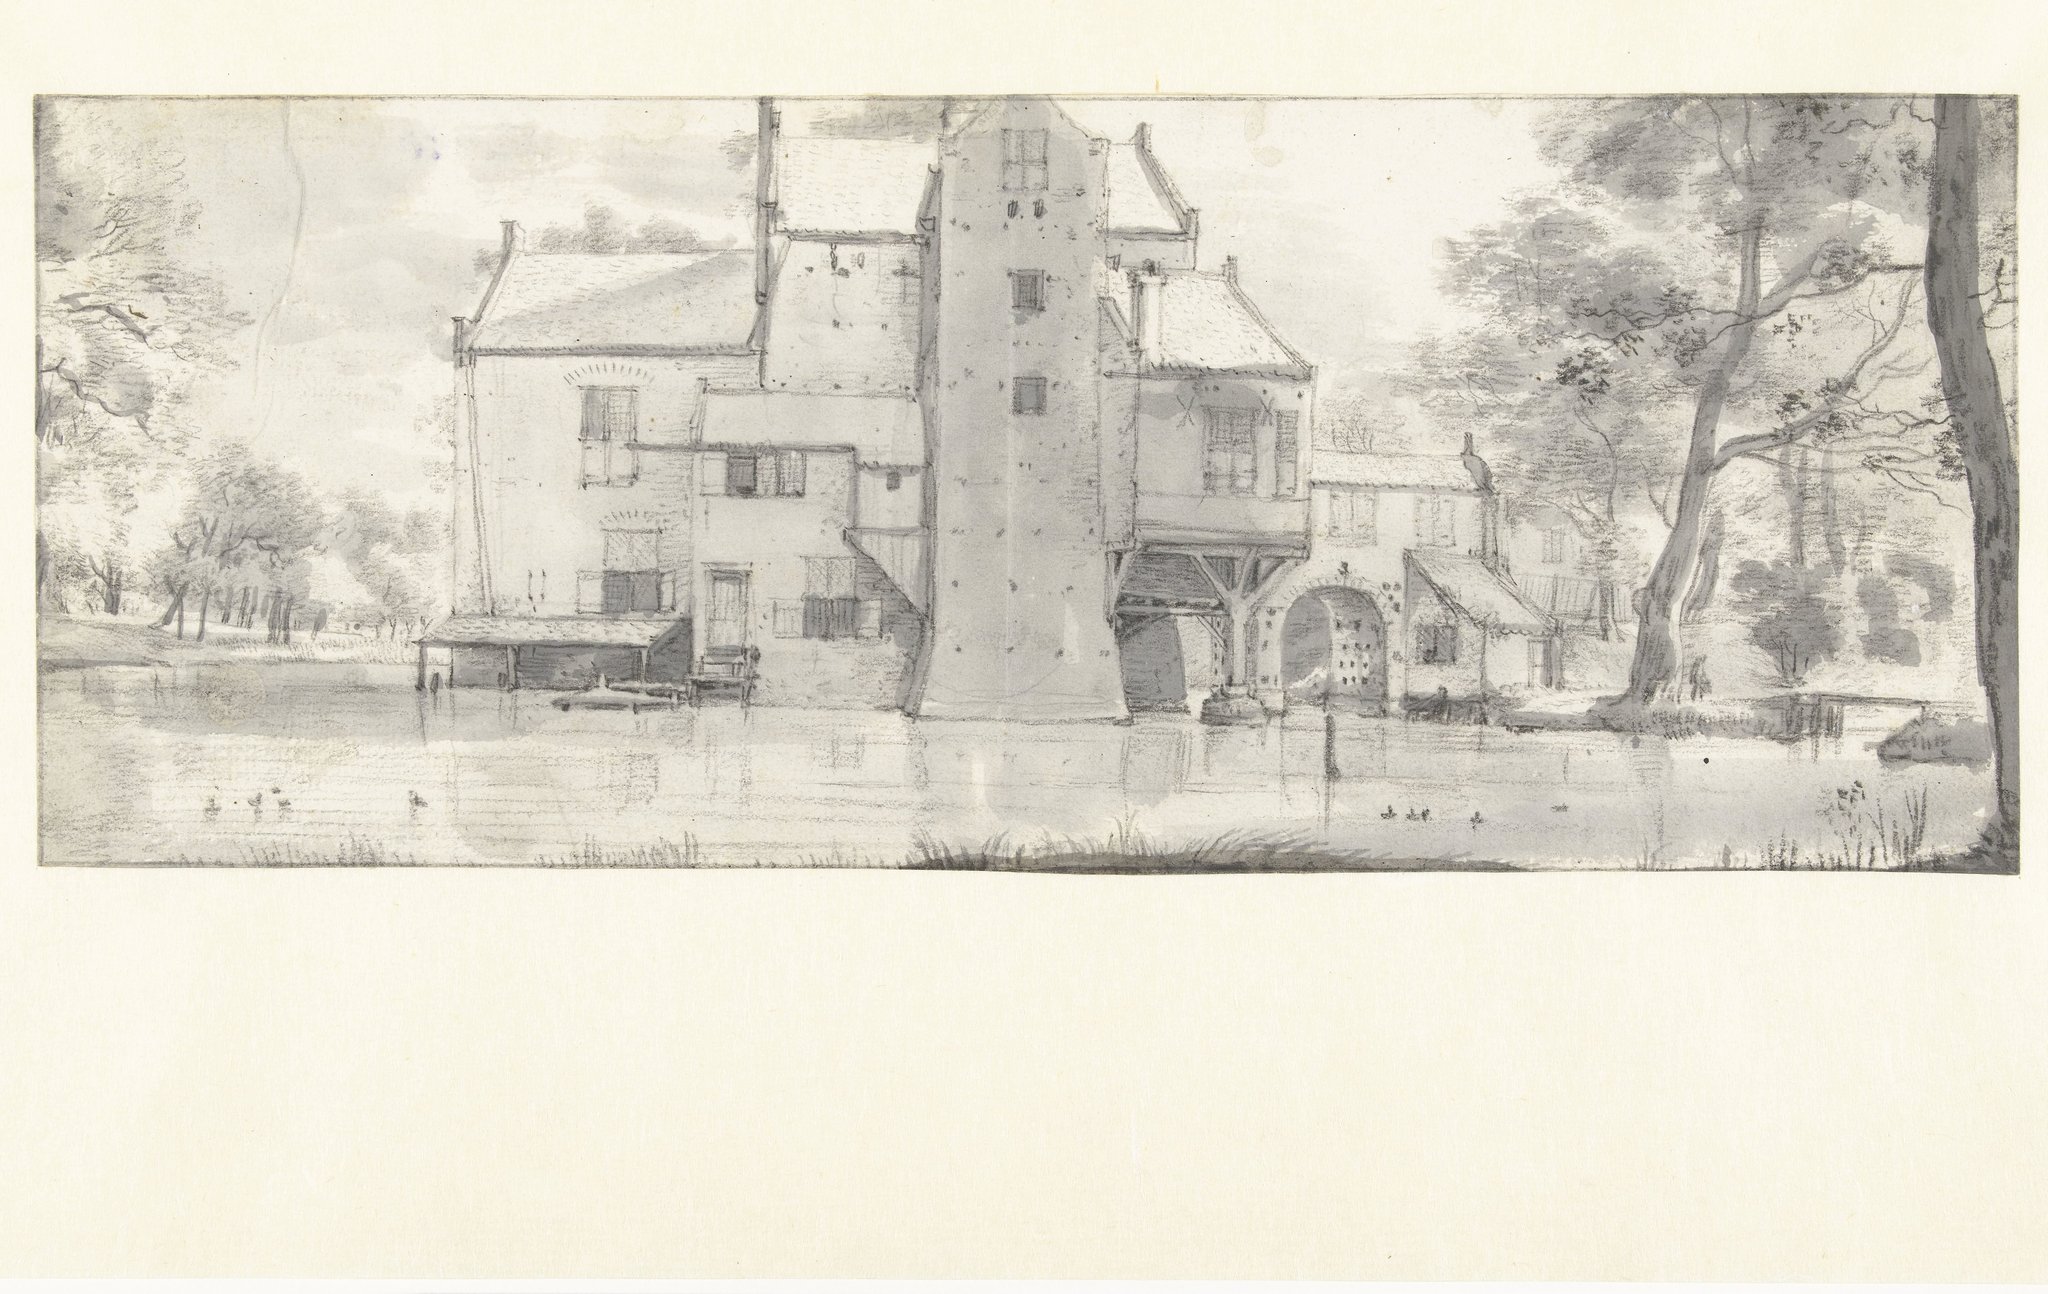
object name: drawing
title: View of Kasteel Hagestein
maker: roelant roghman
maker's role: draughtsman, painter, print maker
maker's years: 1627-1692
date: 1646-1647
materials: chalk, ink, paper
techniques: brush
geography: hagestein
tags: castle